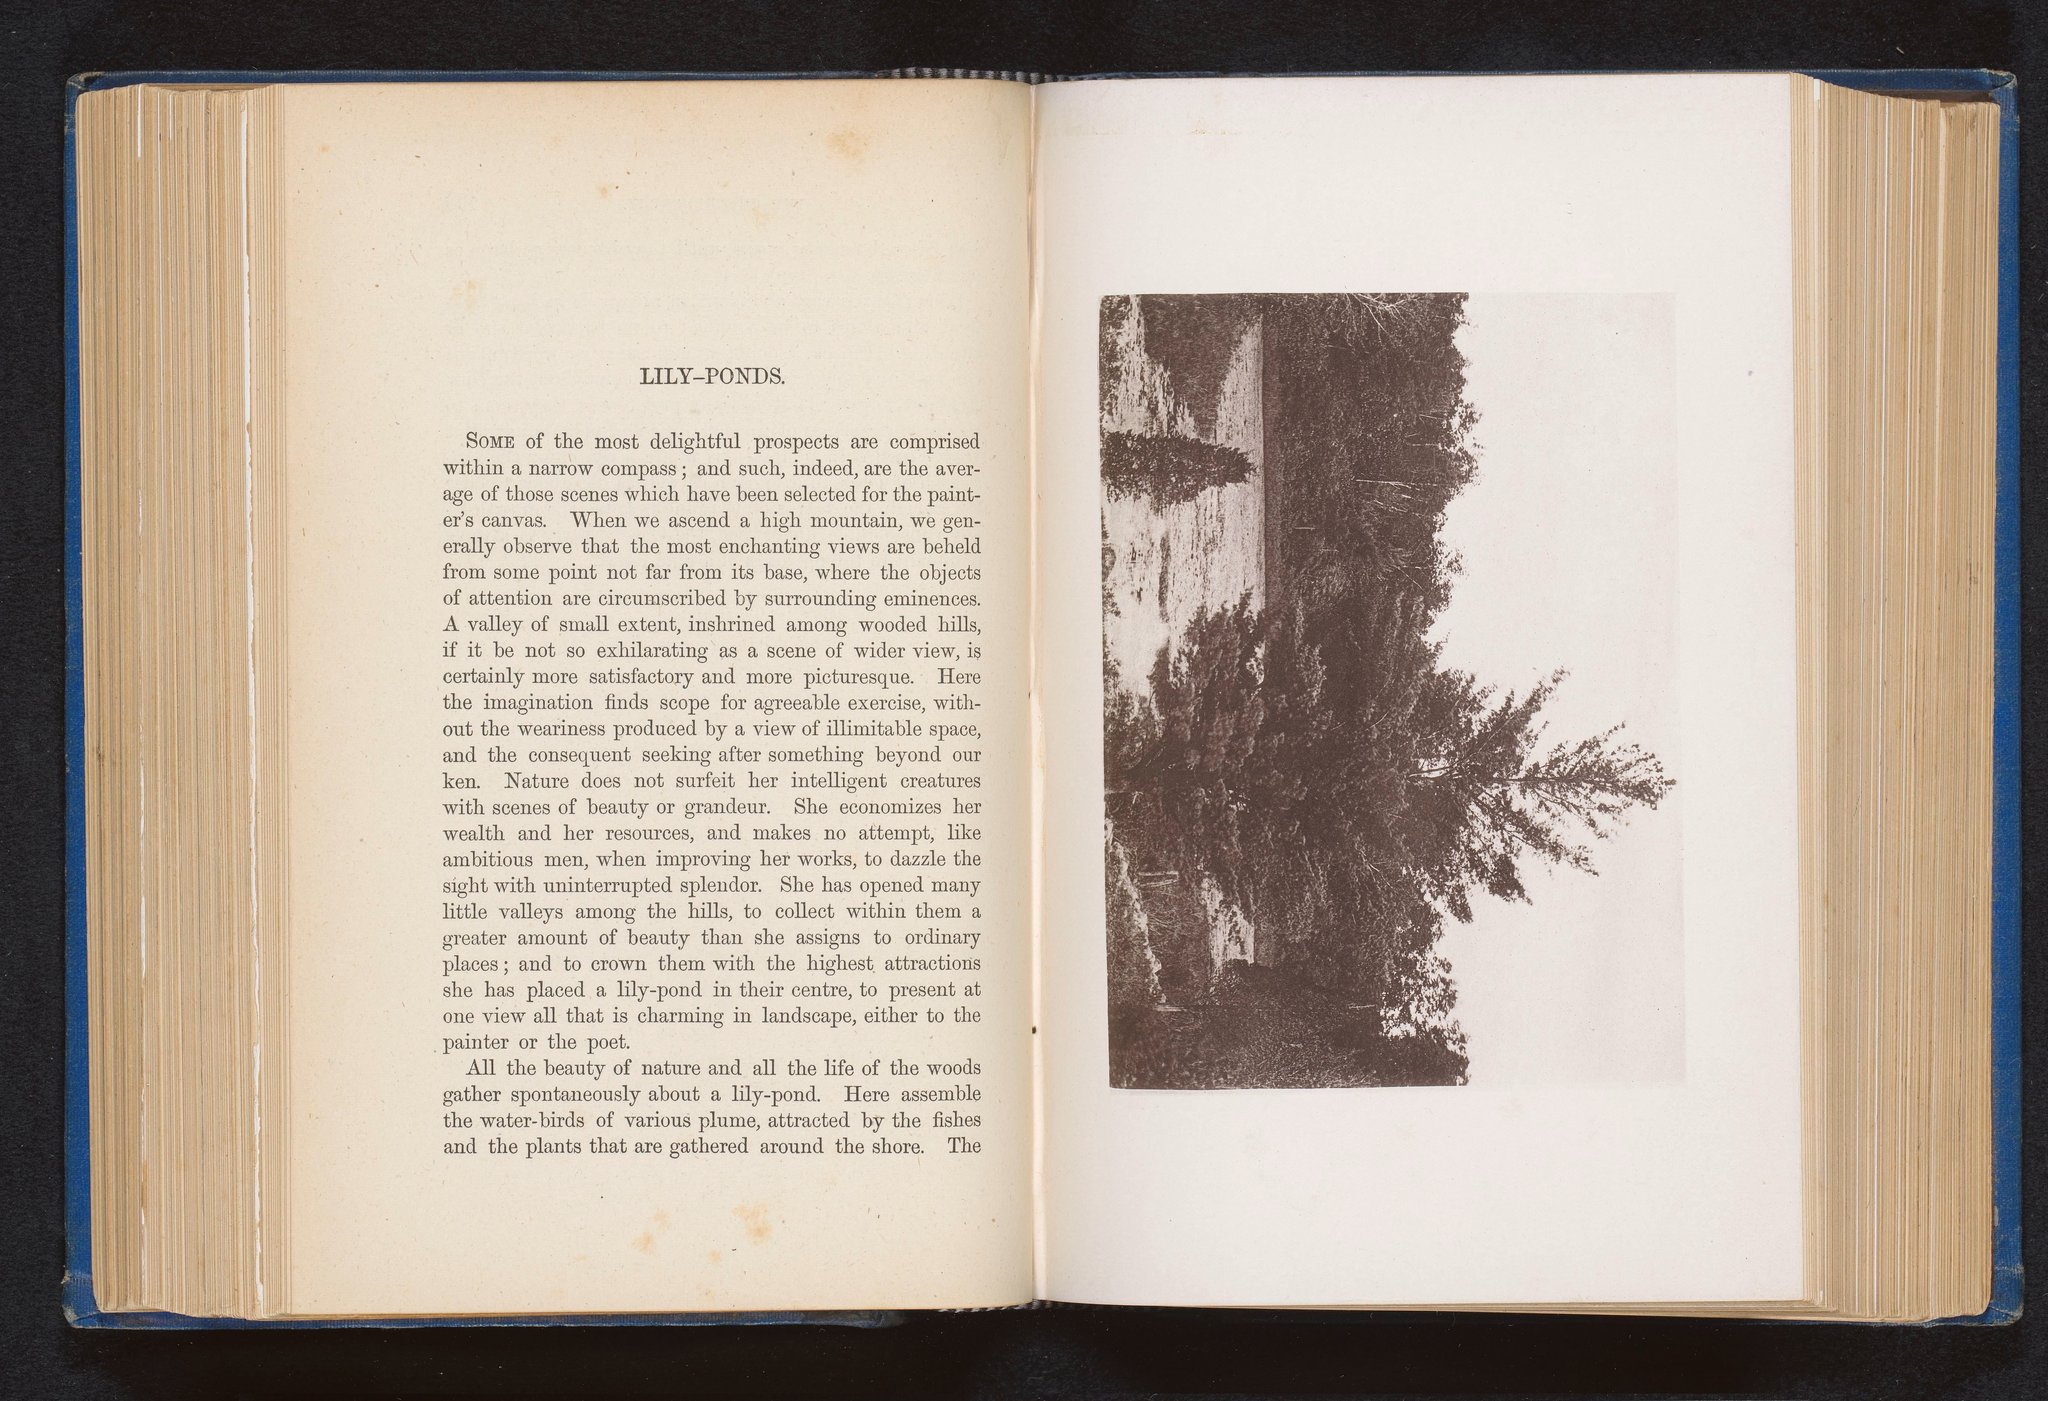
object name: photomechanical print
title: Gezicht op een vijver met dennenbomen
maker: Anonymous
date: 1872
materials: paper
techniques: photograph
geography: waltham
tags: landscapes, pond, pool, trees: pine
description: Prent op tweede ongenummerde pagina na pagina 179.